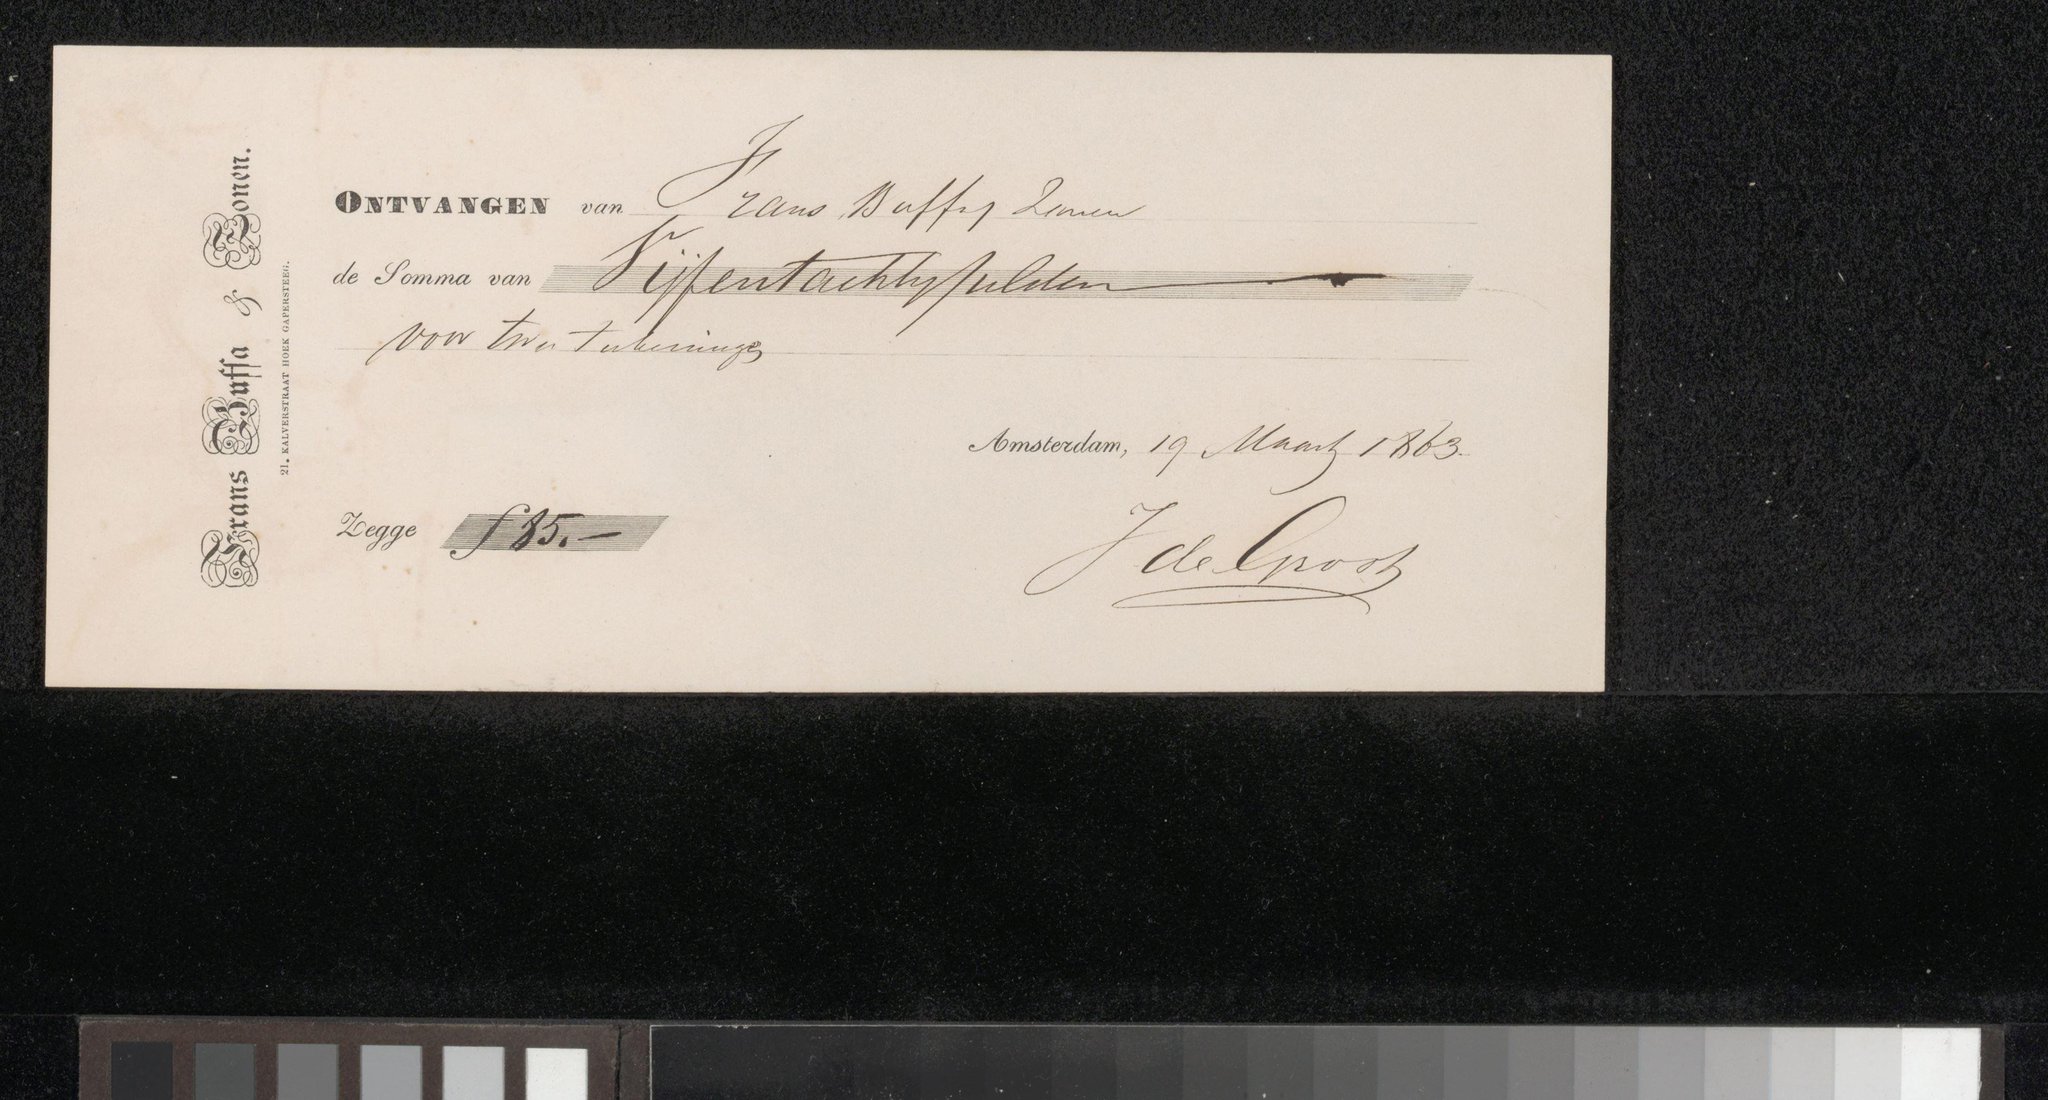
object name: ontvangstbewijs, kwitantie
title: Kwitantie voor Joseph de Groot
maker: joseph de groot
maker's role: draughtsman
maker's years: 1828-1899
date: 1863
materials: ink, paper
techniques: pen, printing, writing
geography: amsterdam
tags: drawing, money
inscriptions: collector's mark: Lugt 2233